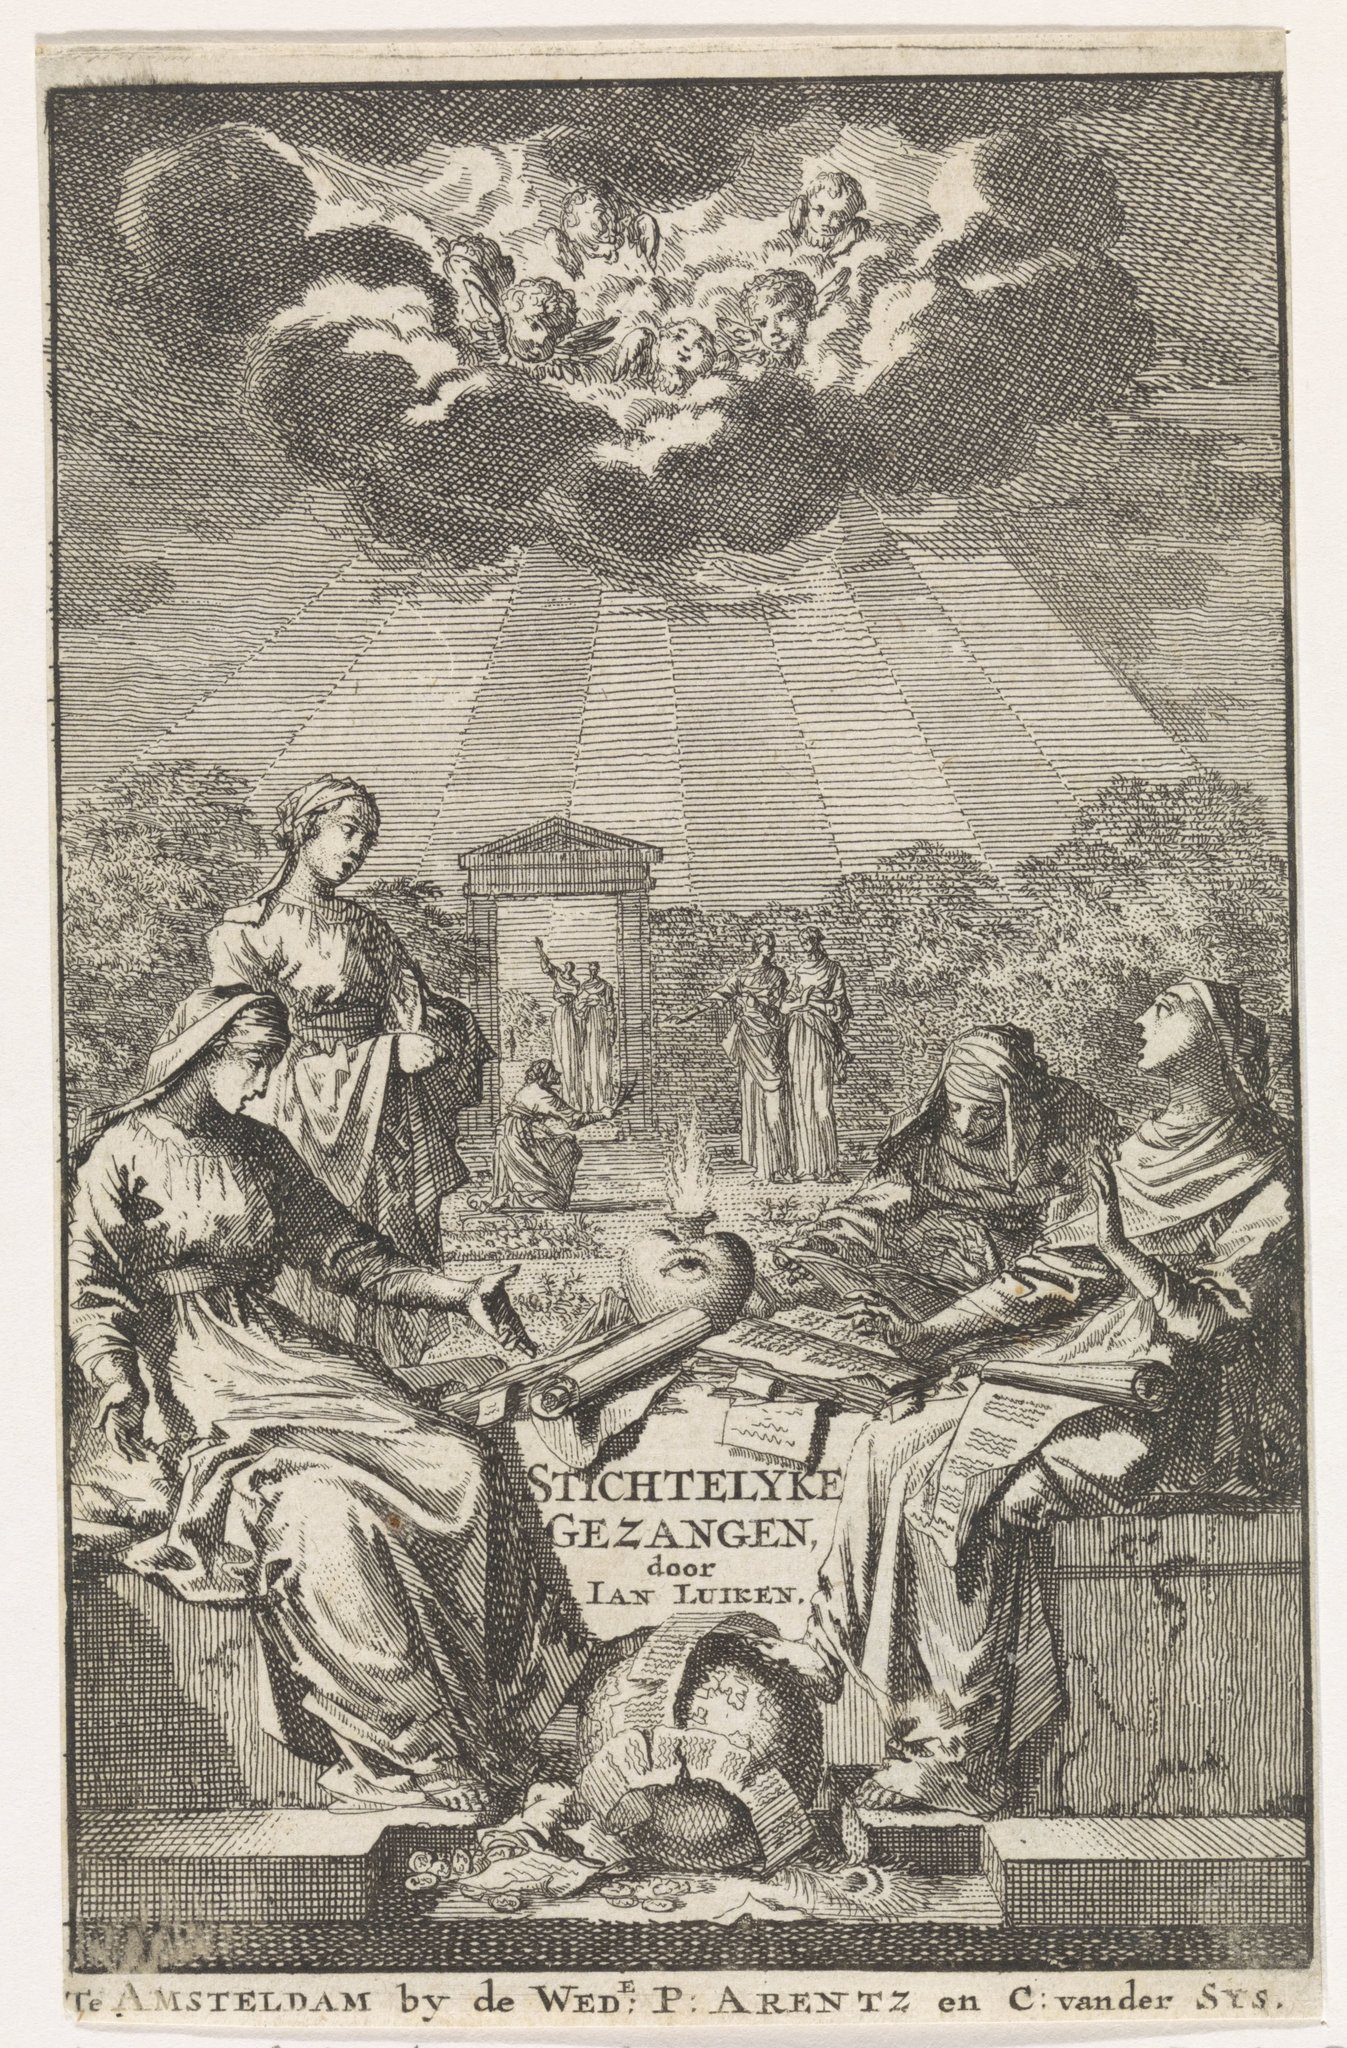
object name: print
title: Vrouwen aanschouwen een brandend hart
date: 1704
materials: paper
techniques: etching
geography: amsterdam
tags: cherubs, i.e. children's heads with wings, garden, the sacred heart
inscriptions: collector's mark: Lugt 2228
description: In een tuin aanschouwen vier vrouwen een brandend hart, symbool van goddelijke liefde. De twee vrouwen op de voorgrond vertreden samen een wereldbol. Vanuit een wolk in de lucht kijkt een groep cherubijnen toe.